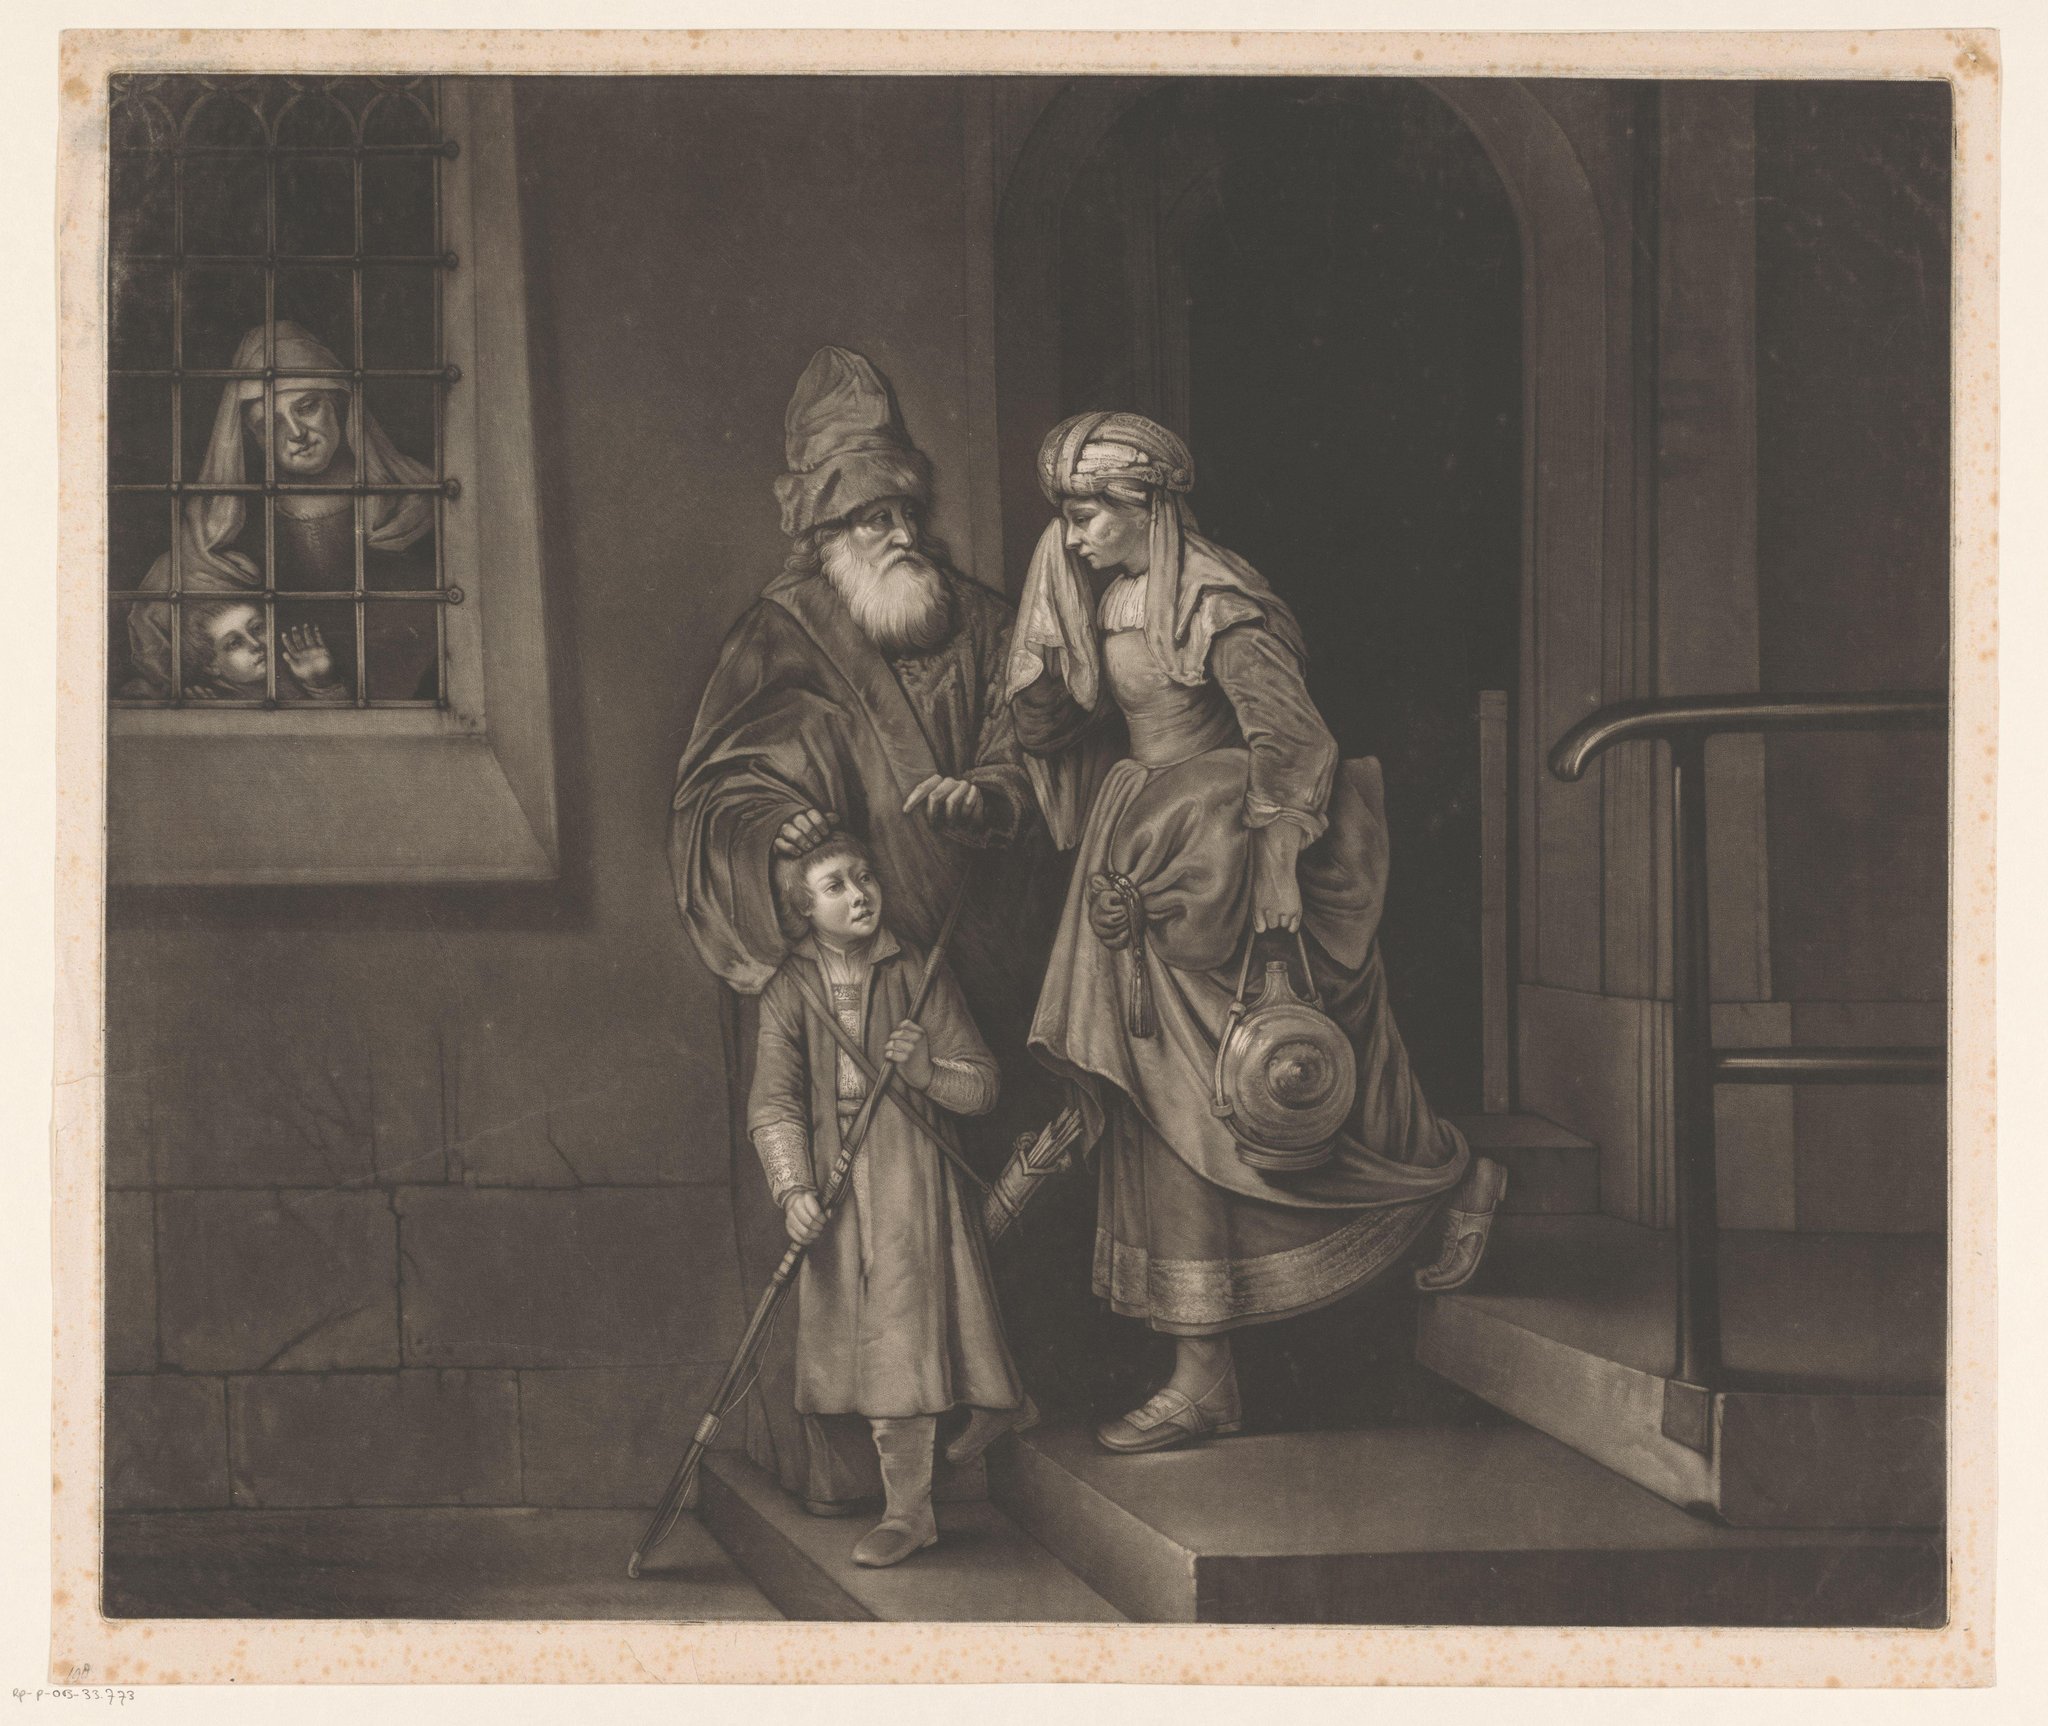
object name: print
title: Abraham verstoot Hagar en Ismaël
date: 1752-1794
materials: paper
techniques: mezzotint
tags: the banishment of hagar and ishmael (genesis 21:9-21)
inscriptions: collector's mark: Lugt 240